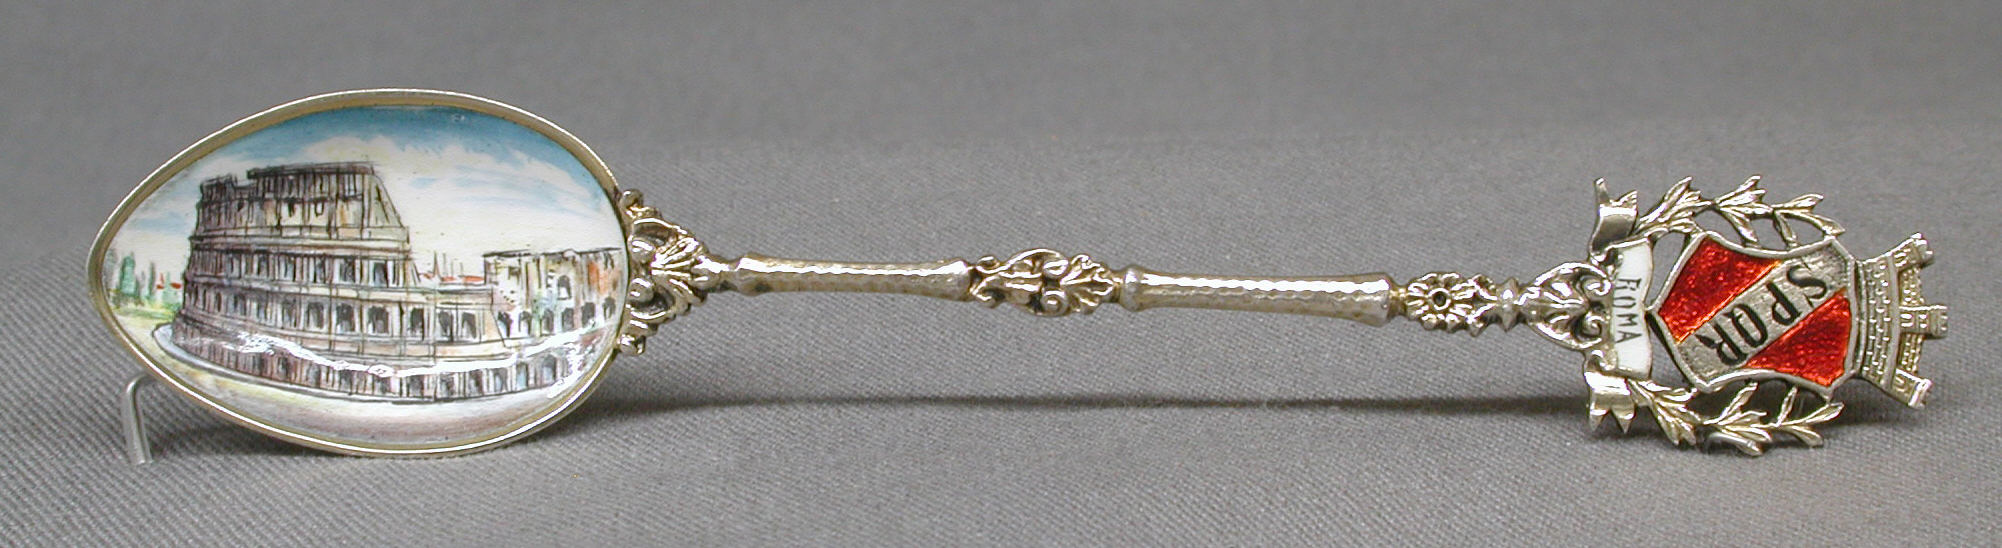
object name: souvenir spoon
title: Souvenir spoon with view of Roman Colosseum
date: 1867-1900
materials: enamel, silver gilt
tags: ruins,coat of arms